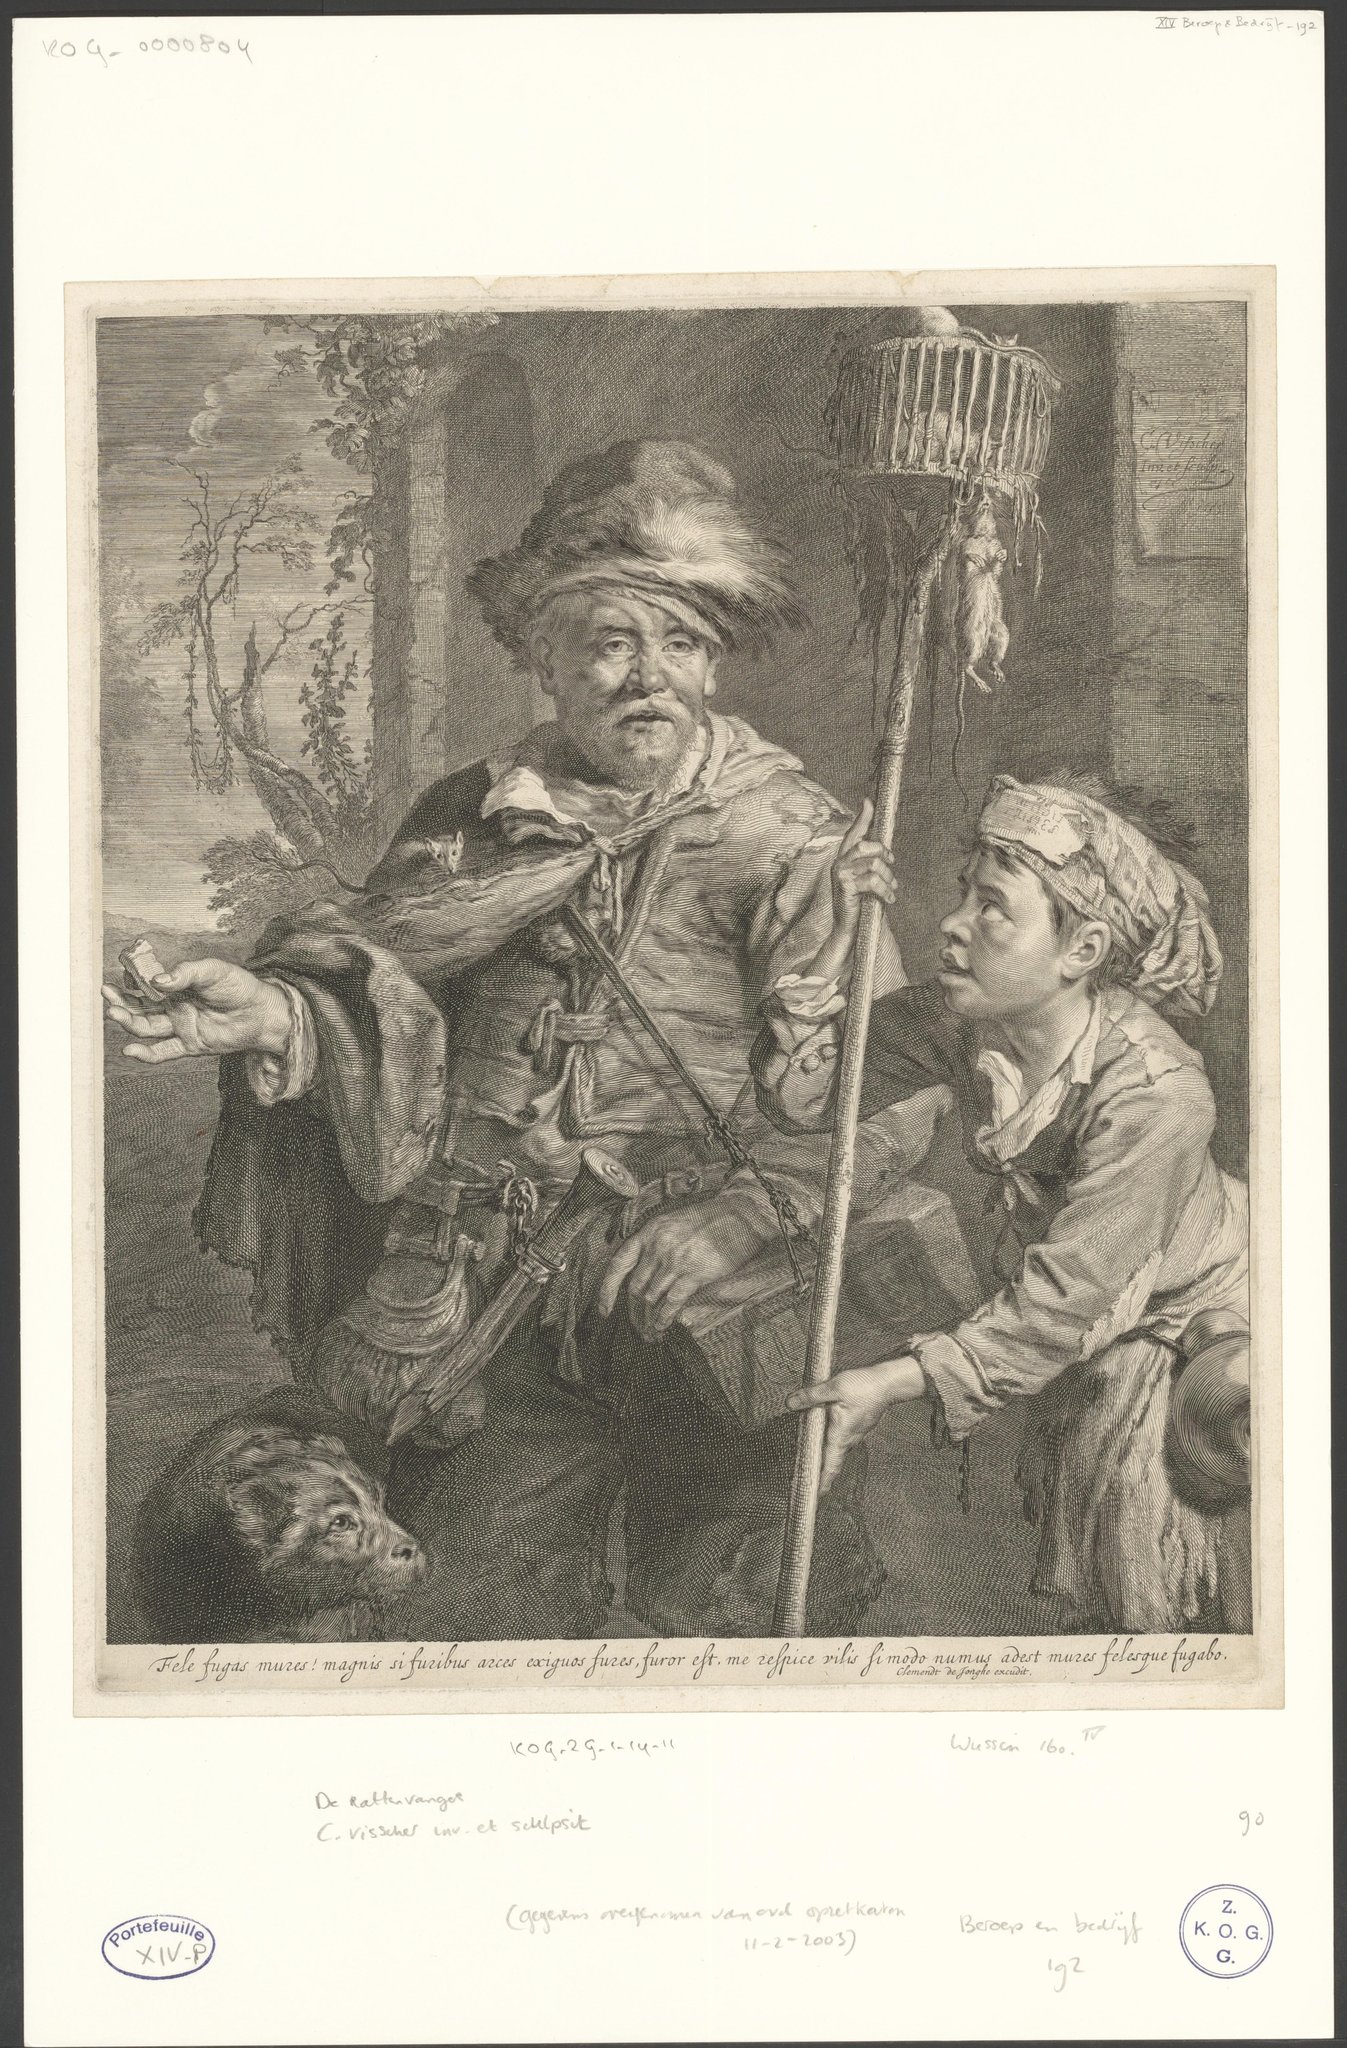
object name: print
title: De rattenvanger met zijn knecht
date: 1655-1670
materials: paper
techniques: engraving, etching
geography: amsterdam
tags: rat exterminator, dog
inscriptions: collector's mark, collector's mark: Lugt 1641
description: Een rattengifverkoper met zijn knecht en hond. De jongen houdt een lange stok vast met een kooitje met dode en levende ratten. De verkoper draagt een tas en gereedschap met zich mee, op zijn mantel loopt een rat. Op een kist die hij op zijn heup draagt staan de wapens van Leiden en Amsterdam. Met onderschrift in het Latijn. Onderwerpsrubrieken binnen de Atlas Zeden en Gewoonten: Mannelijk beroep en bedrijf: Marskramers, straatventers, straatslijpers, bedelaars, straatvertooningen enz.